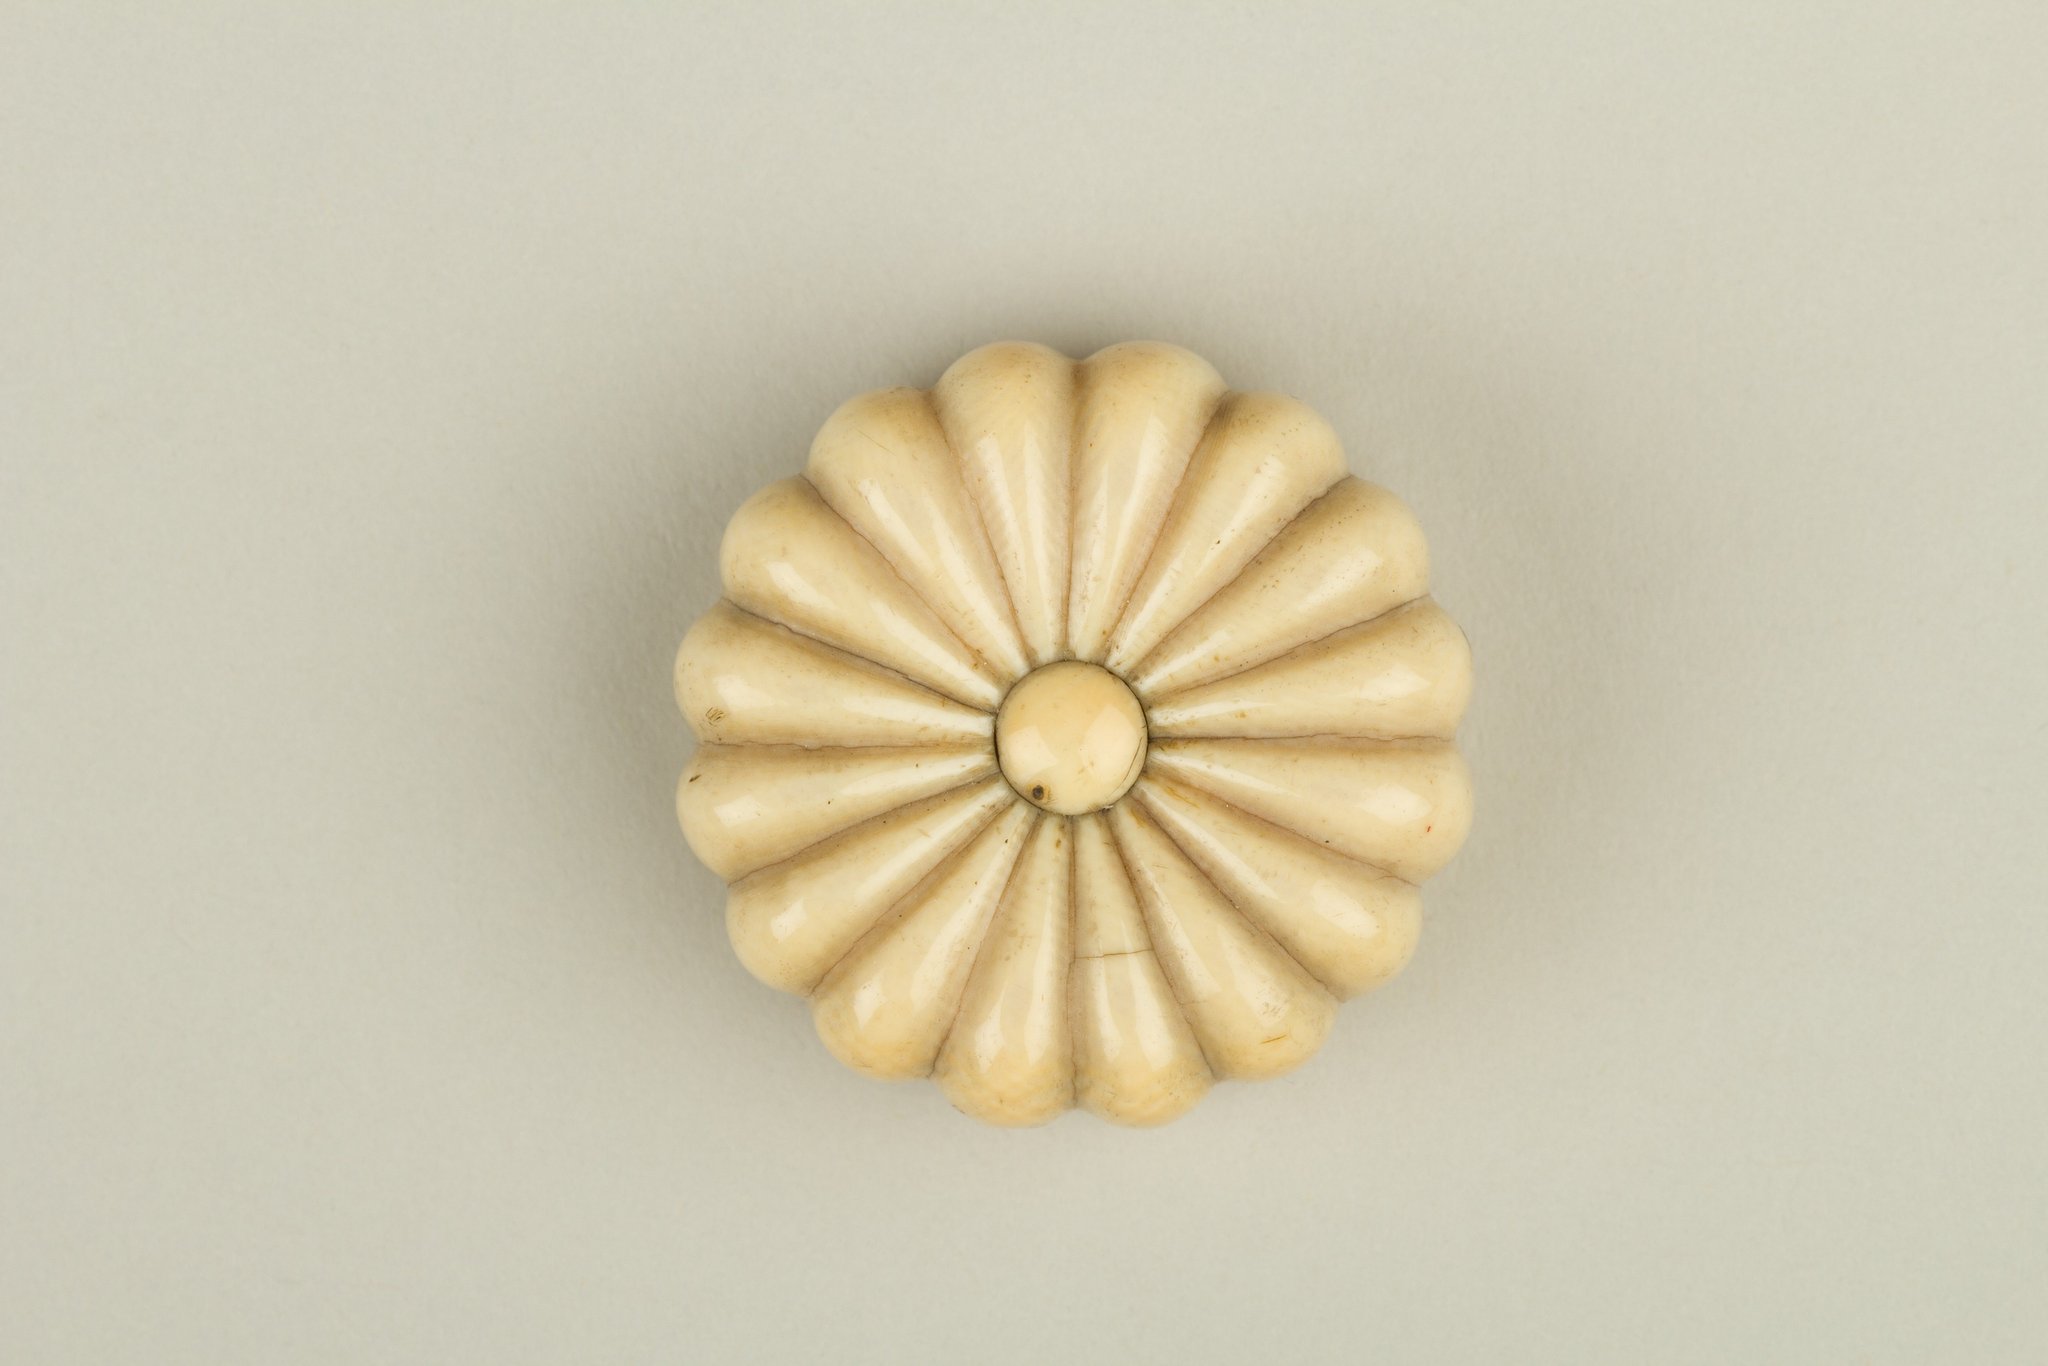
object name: netsuke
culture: japanese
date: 1801-1900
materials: ivory